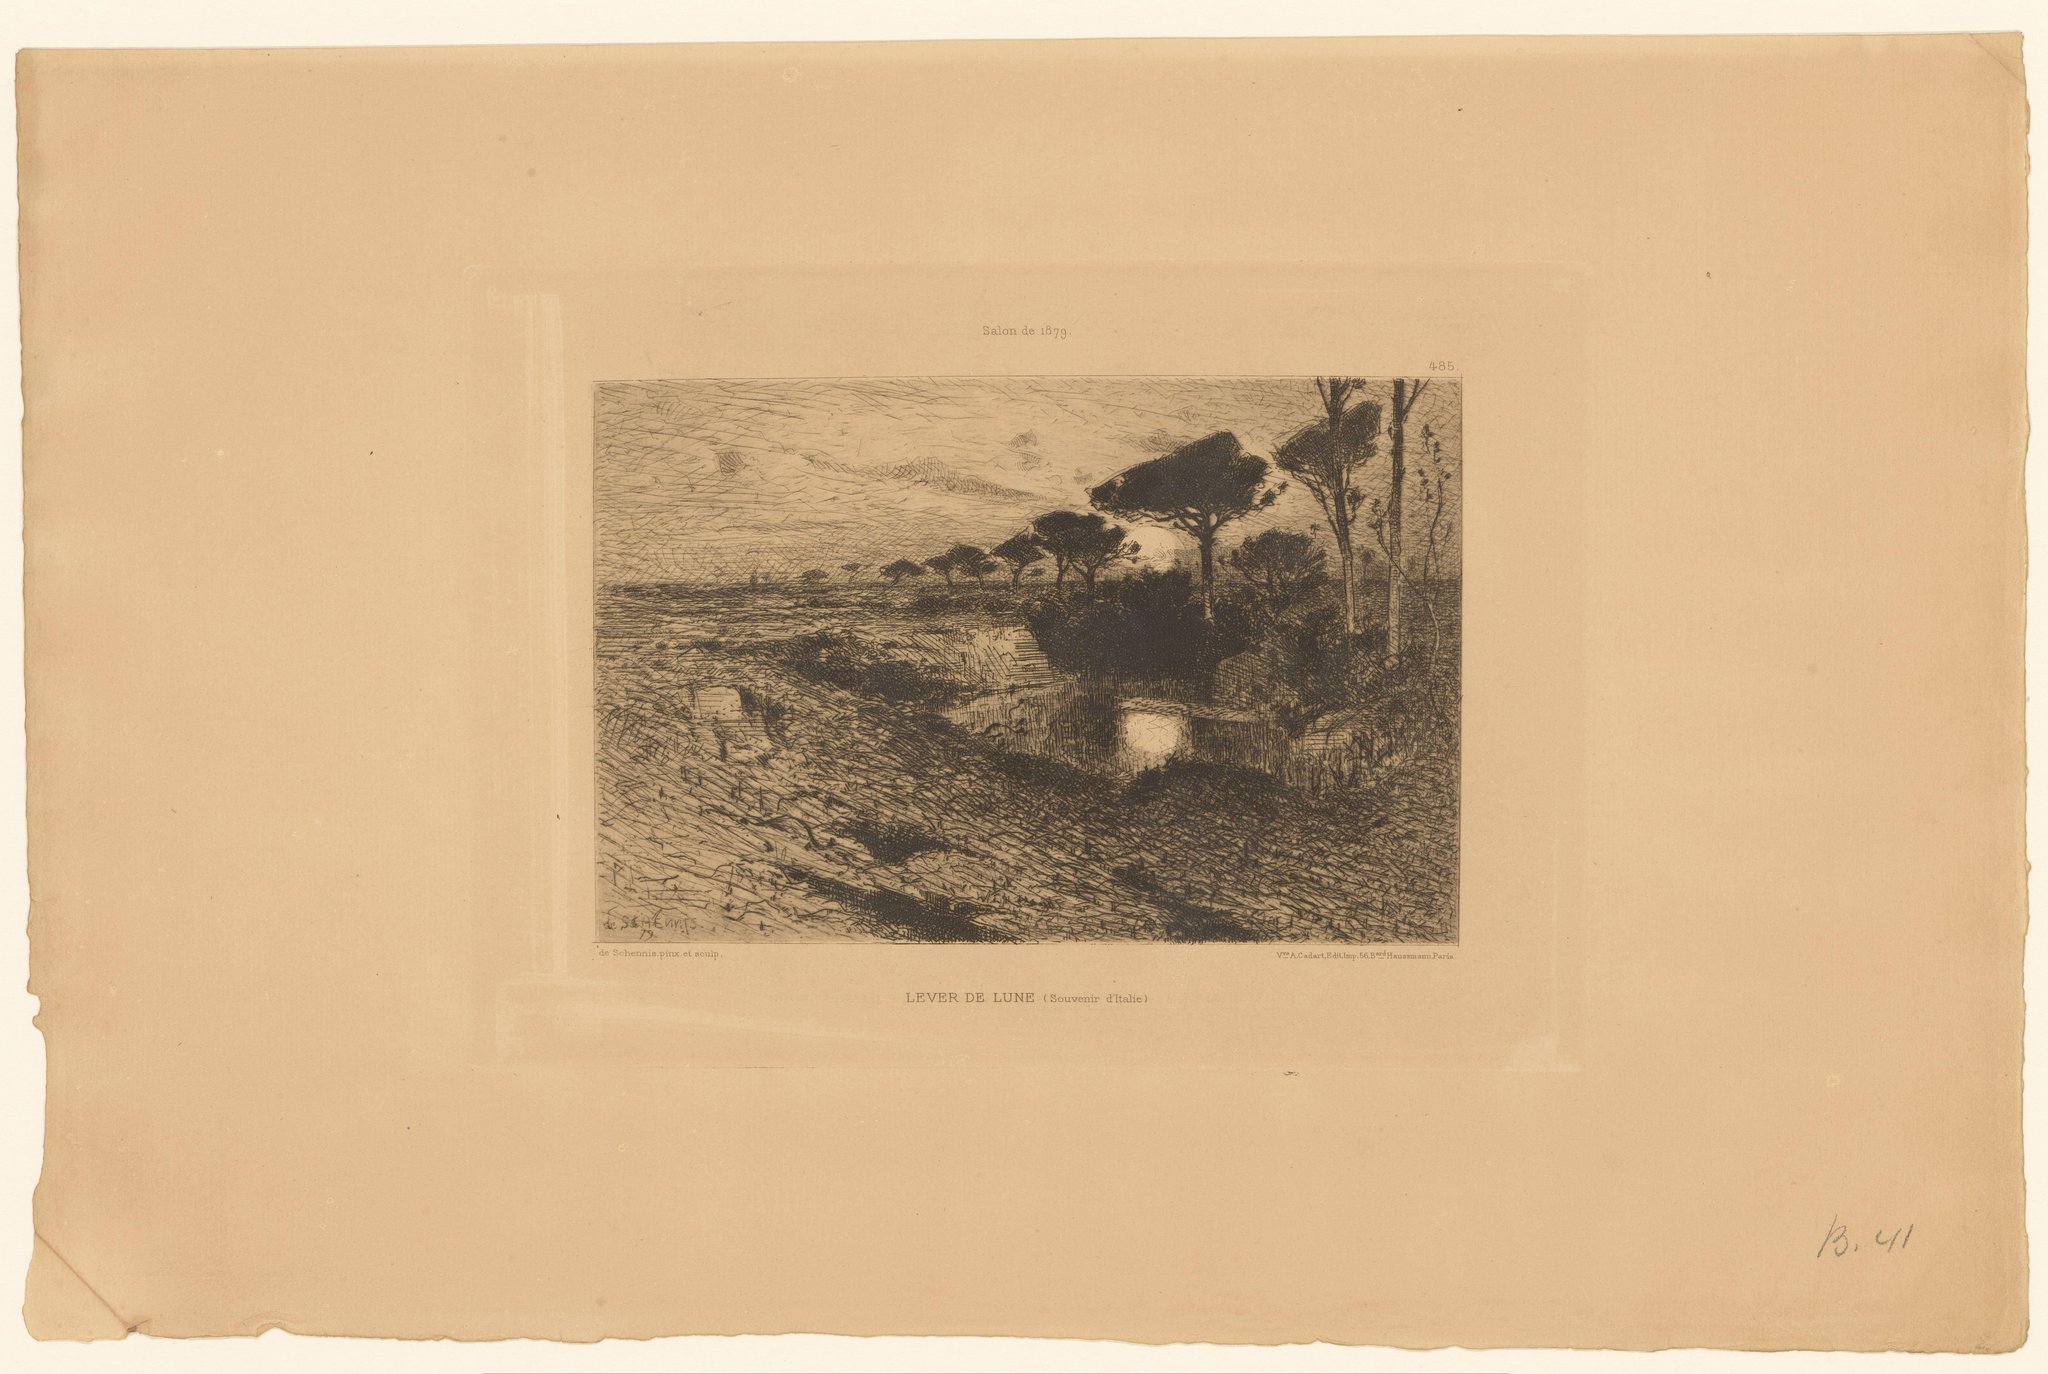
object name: print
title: Nachtlandschap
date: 1879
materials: paper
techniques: etching, intaglio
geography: paris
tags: night ~ landscape (sometimes titled 'nox')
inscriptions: collector's mark: Lugt 2233